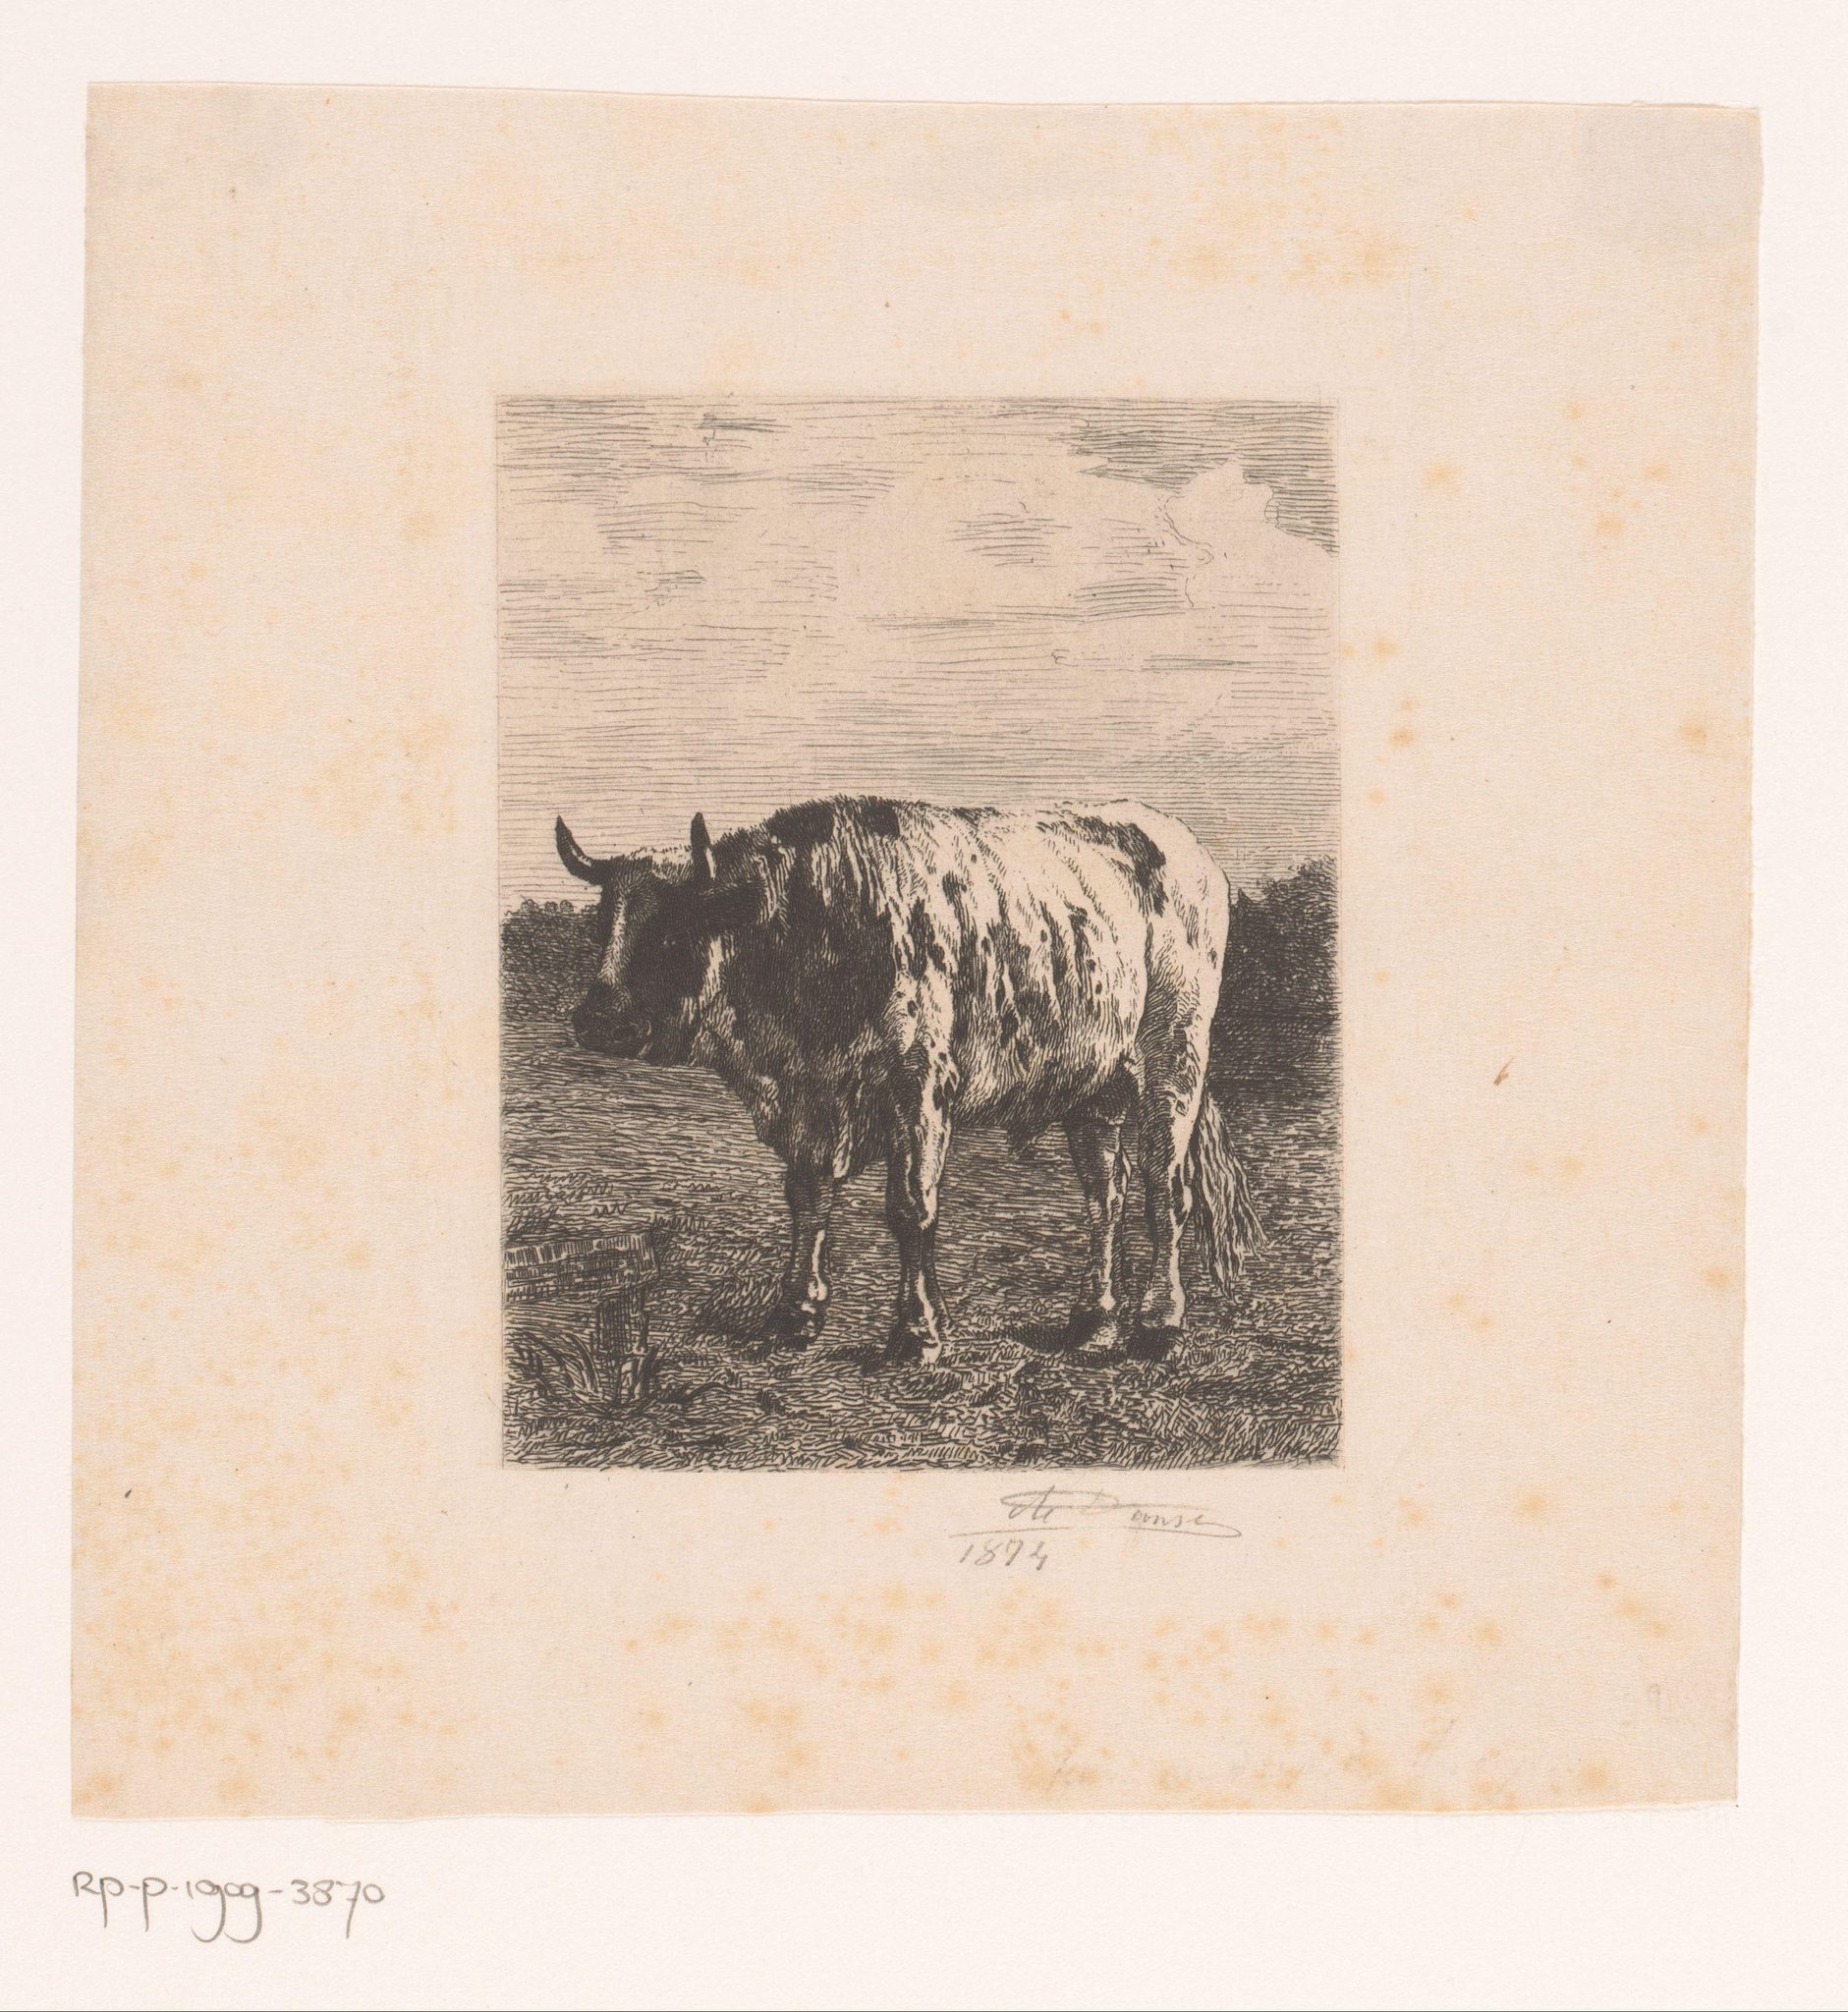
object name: print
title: Stier in de wei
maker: auguste danse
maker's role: print maker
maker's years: 1829-1929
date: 1874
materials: paper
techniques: etching, intaglio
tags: bull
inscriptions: collector's mark: Lugt 2228